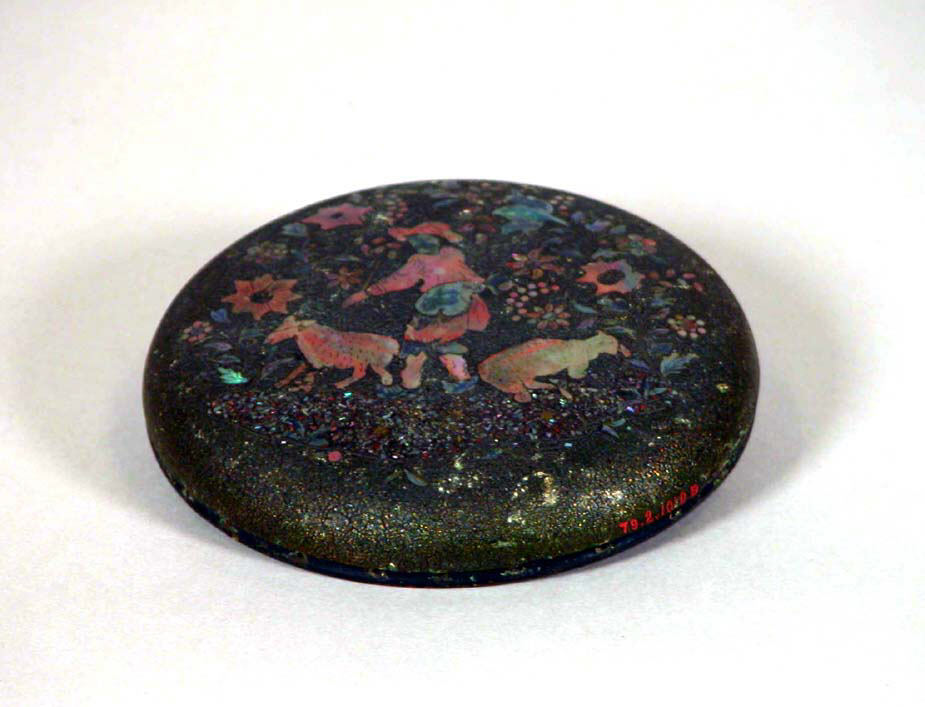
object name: cover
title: Cover for a Porcelain Jar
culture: chinese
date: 1701-1800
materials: lacquer, mother of pearl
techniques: inlay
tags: human figures,animals,flowers